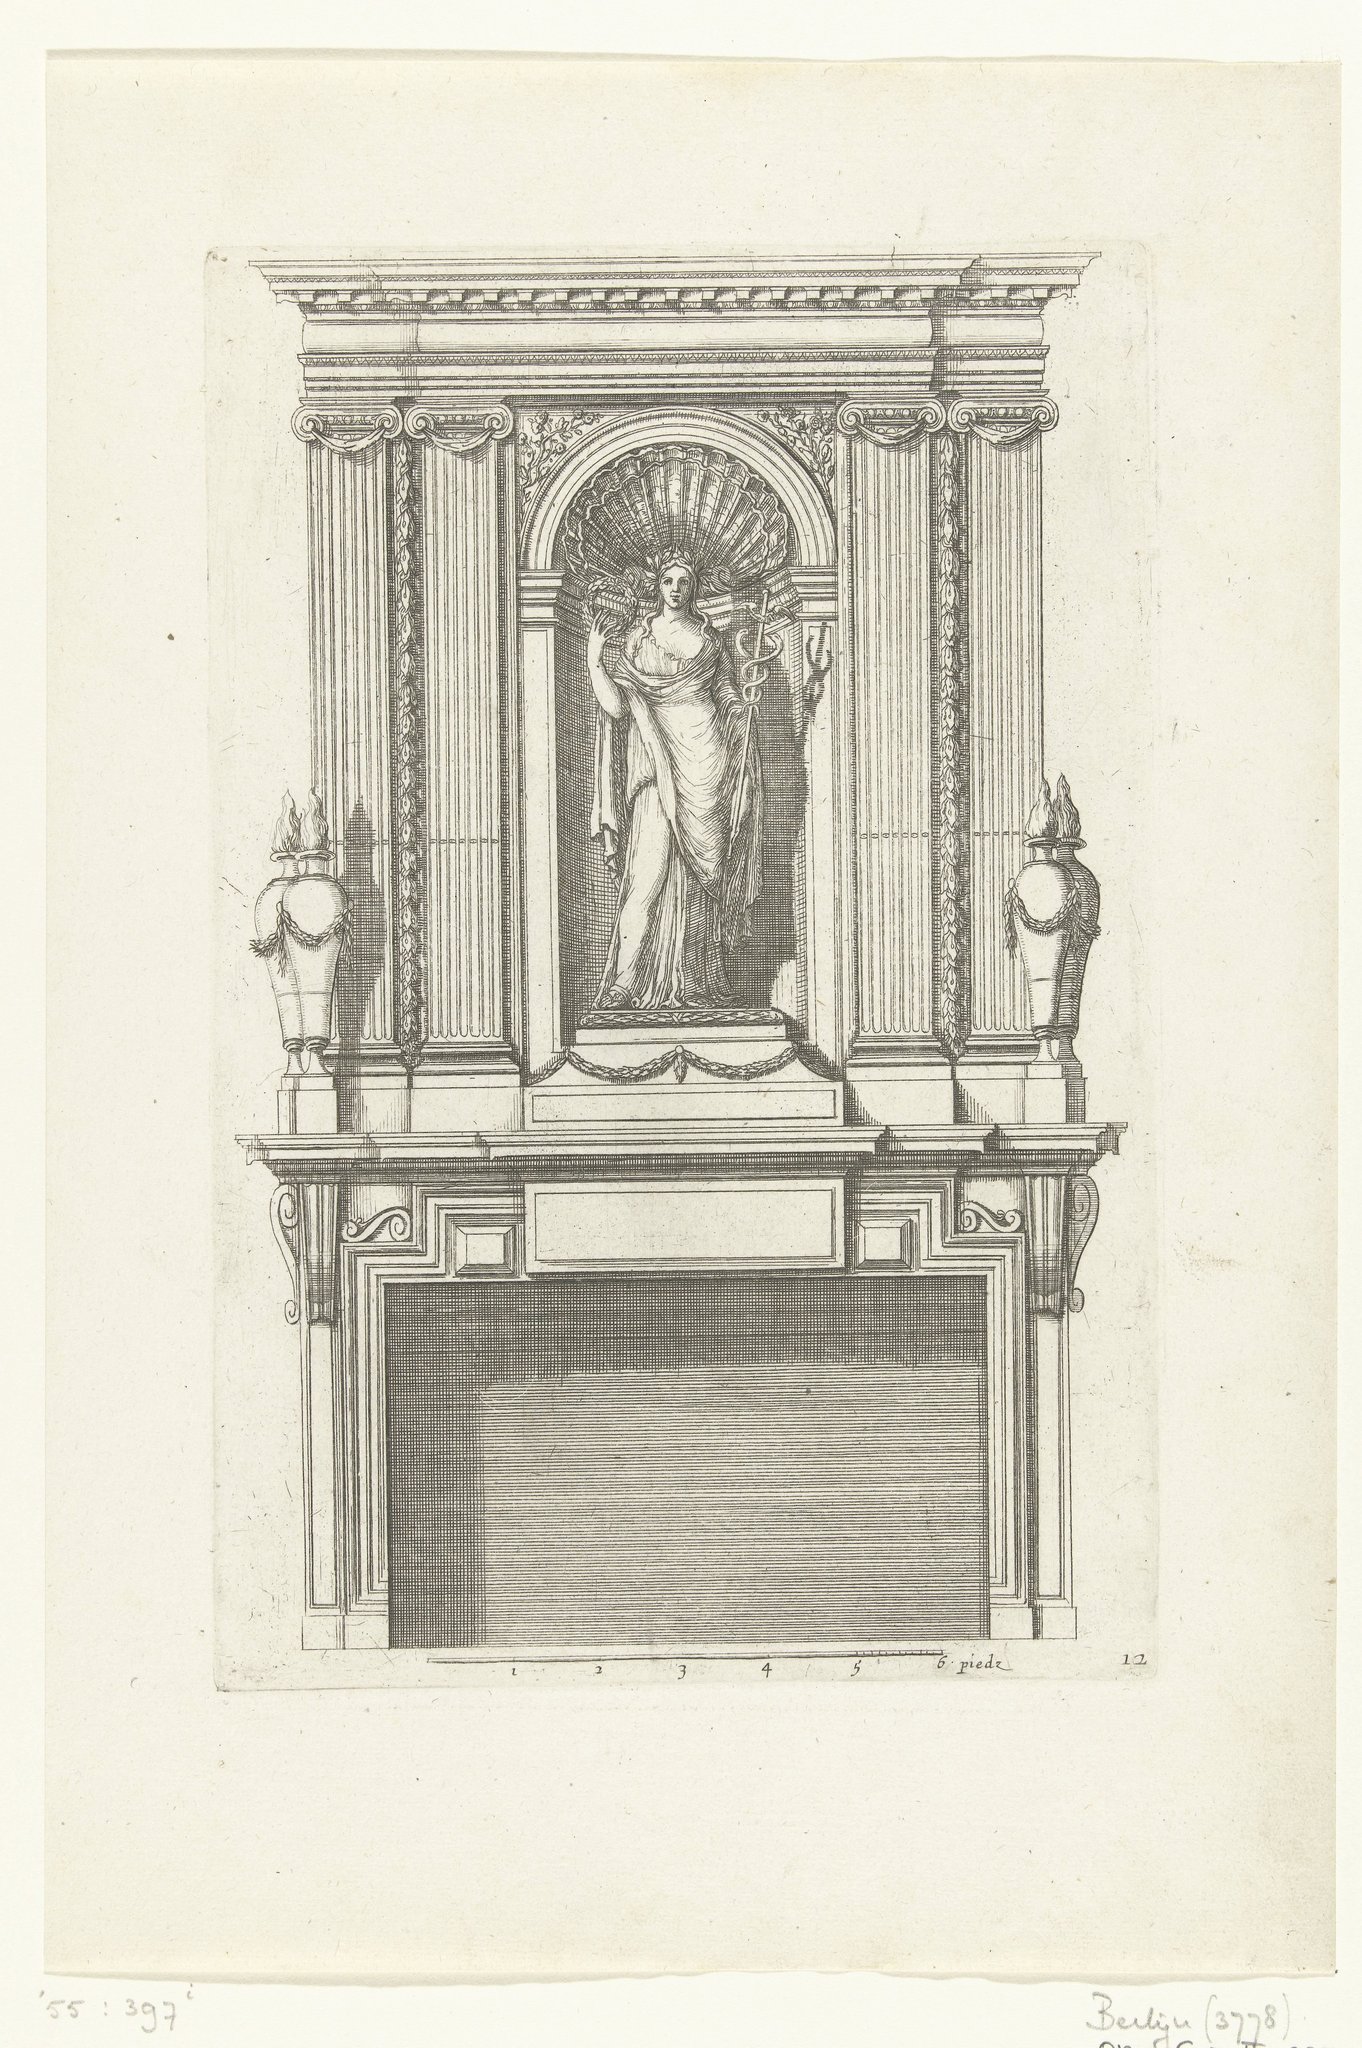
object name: print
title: Divers Desseins de cheminées à la royale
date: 1655-1657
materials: paper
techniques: engraving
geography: paris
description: De vrouw heeft een lauwerkrans en een caduceus vast.